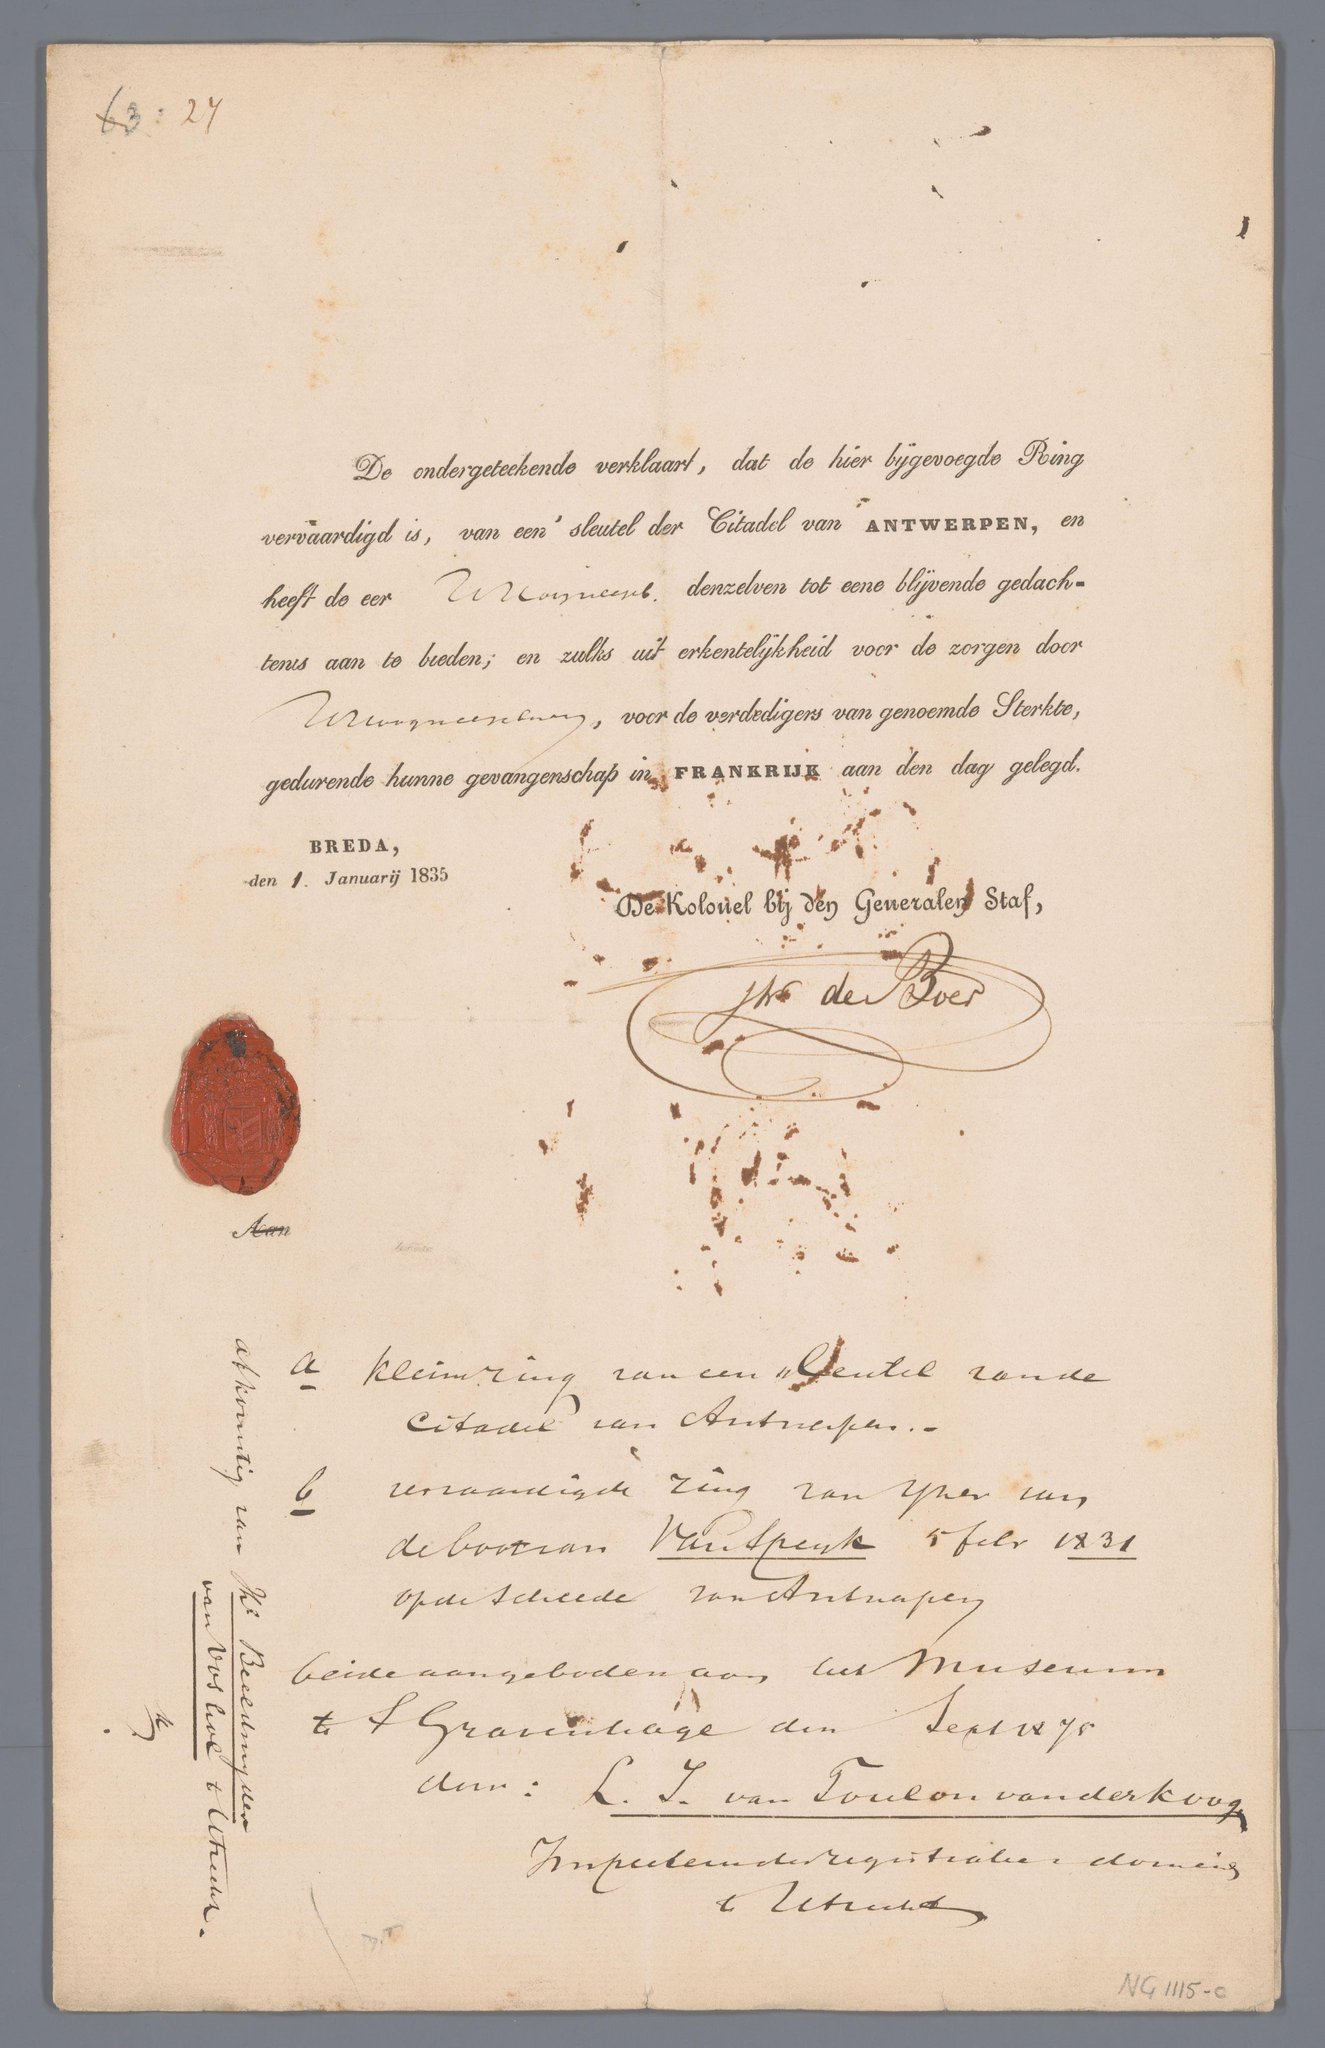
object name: verklaring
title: Dubbele verklaring van de echtheid van twee ringen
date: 1835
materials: ink, paper, red lacquer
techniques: printing, pen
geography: netherlands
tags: amsterdam, antwerp, jan van speyk, netherlands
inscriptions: signature: ‘L. I. van Toulon van der Koog’, signature: ‘Jhr. de Boer’, date: ‘den 1. Januarij 1835’, inscription: ‘... b. vervaardigde ring van yzer van / de boot van Van Speyk 5 febr. 1831 / op de Schelde van Antwerpen...’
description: On 5 October 1833 the amount raised by the lottery was announced. After costs the lottery made ? 6484,98. A total of 5723 tickets had been sold and 911 prizes awarded.